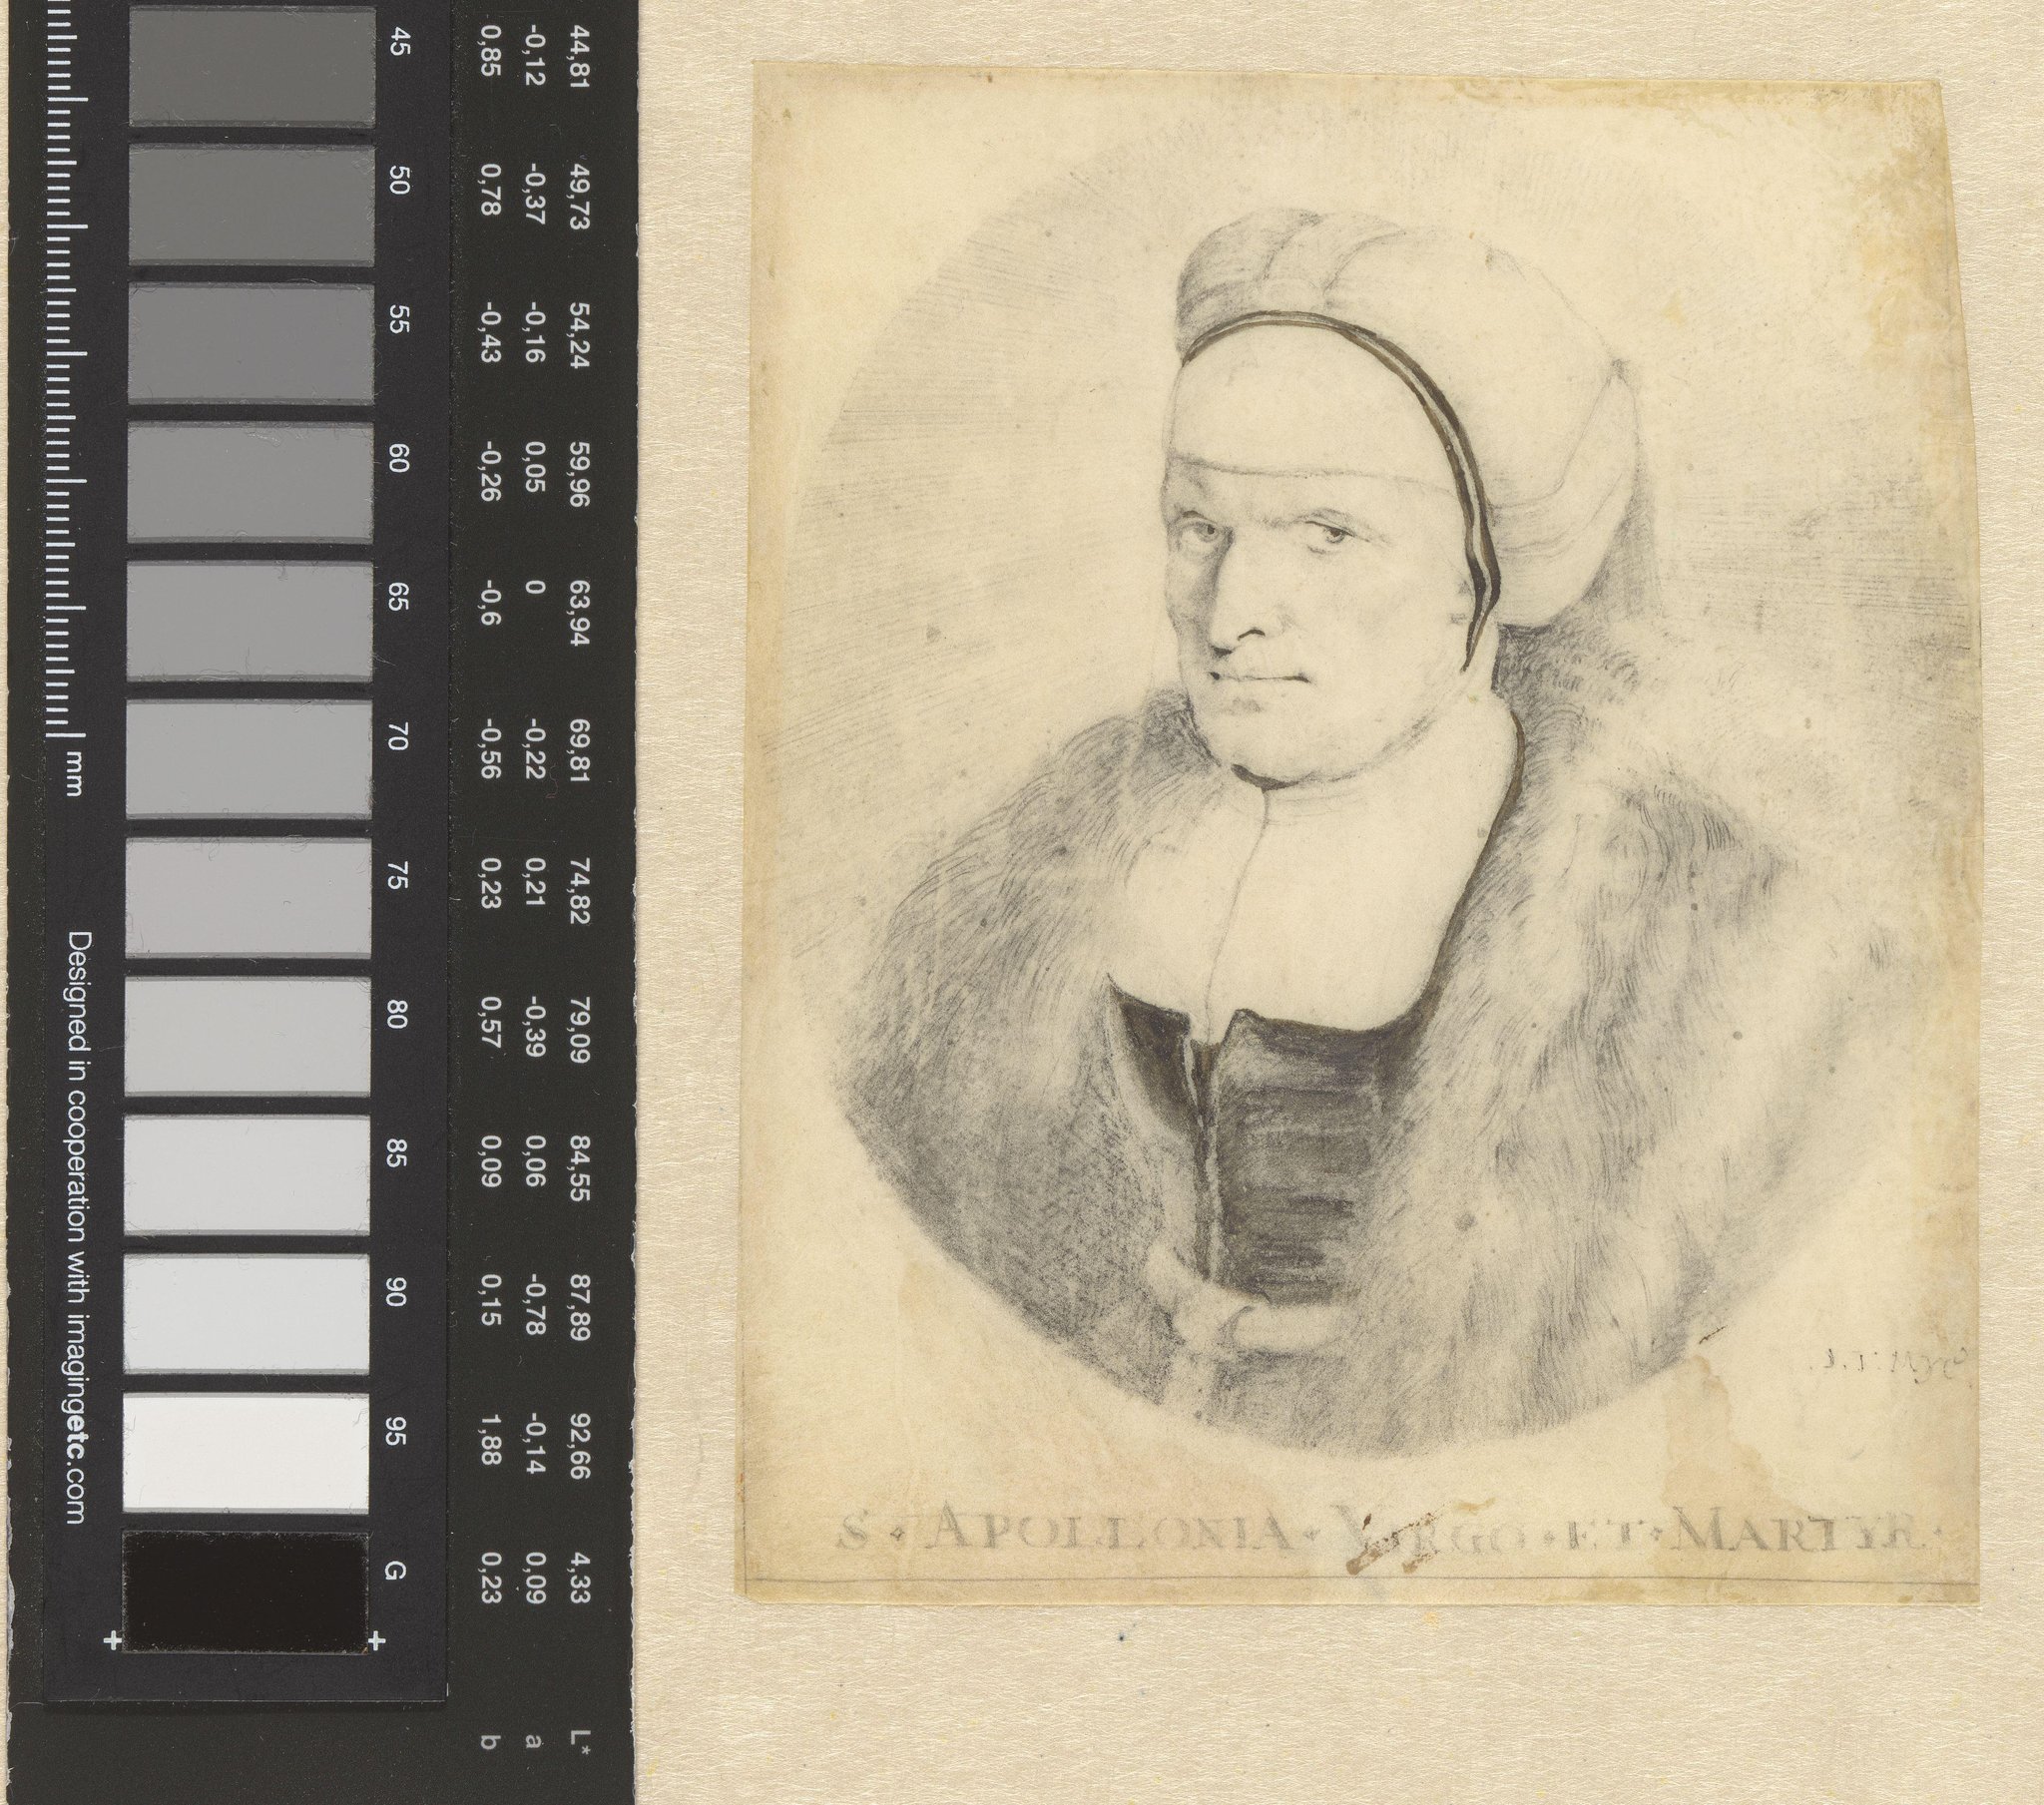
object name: drawing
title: S. Apollonia Virgo et Martyr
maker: isaac van der mye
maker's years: 1602-1656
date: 1650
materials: graphite, parchment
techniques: brush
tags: anonymous historical person portrayed alone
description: Ovaal portret in driekwart van een vrouw met muts en brede bontkraag over een donker gewaad.